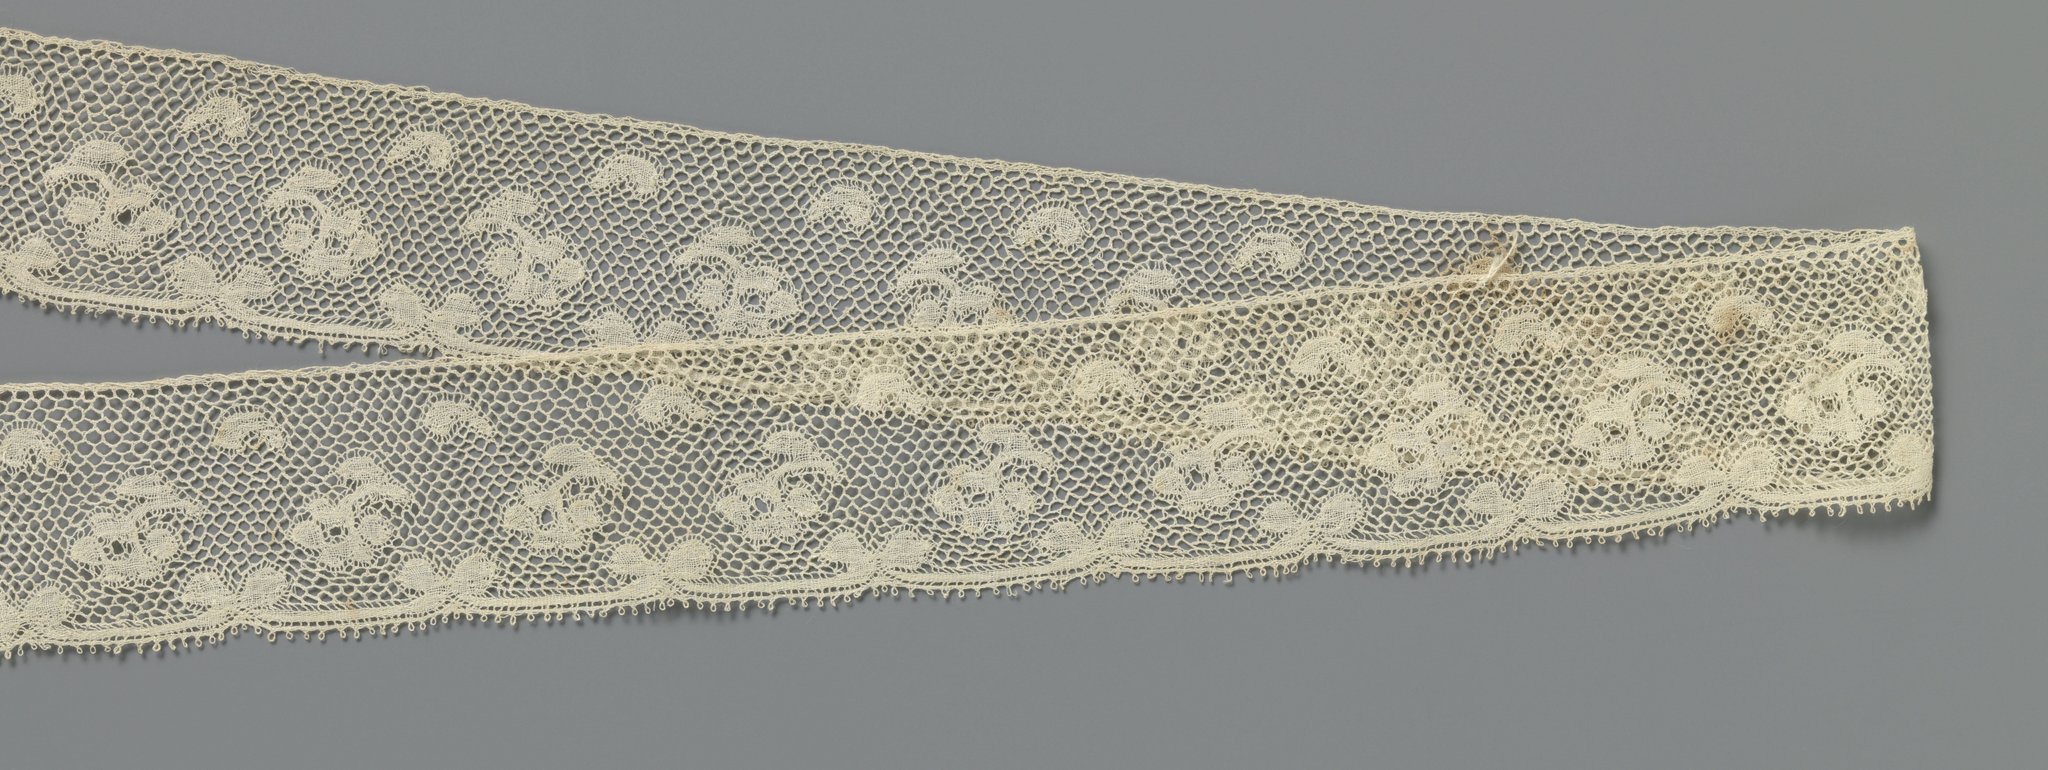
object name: strip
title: Strook kloskant met rozentakjes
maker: Anonymous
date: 1850-1899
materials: cotton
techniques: lace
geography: valenciennes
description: Strook naturelkleurige kloskant, Valenciennes-kant. Het zich herhalende patroon bestaat op de middenlijn van de strook uit een rozetbloem dat aan een gebogen takje naar beneden hangt. Boven de rij rozentakjes die zo ontstaat staat een rij dikke c-vormige blaadjes. Langs de onderzijde van de strook ligt een aaneenschakeling van langgerekte voluten die een zeer flauwe schulpenrand vormen. De motieven zijn met elkaar verbonden door een maasgrond, een ronde Valenciennes-grond. De motieven zijn gemaakt in linnenslag met opengewerkte randjes en een uitsparing in het bloemhart. De bovenzijde van de strook is recht afgewerkt. De flauwe schulpen langs de onderzijde zijn afgewerkt met picots. De korte zijden zijn aan elkaar genaaid.